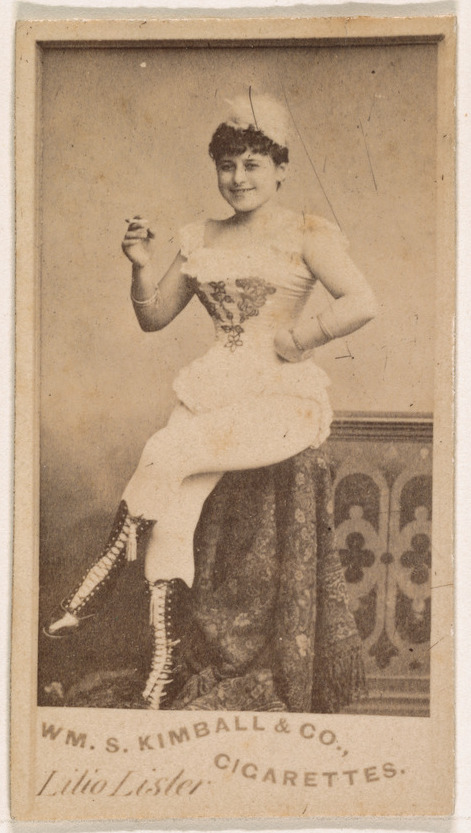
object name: photograph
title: Lilio Lister, from the Actresses series (N203) issued by Wm. S. Kimball & Co.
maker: william s. kimball & company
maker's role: publisher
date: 1889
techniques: color lithograph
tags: portraits,women,actresses